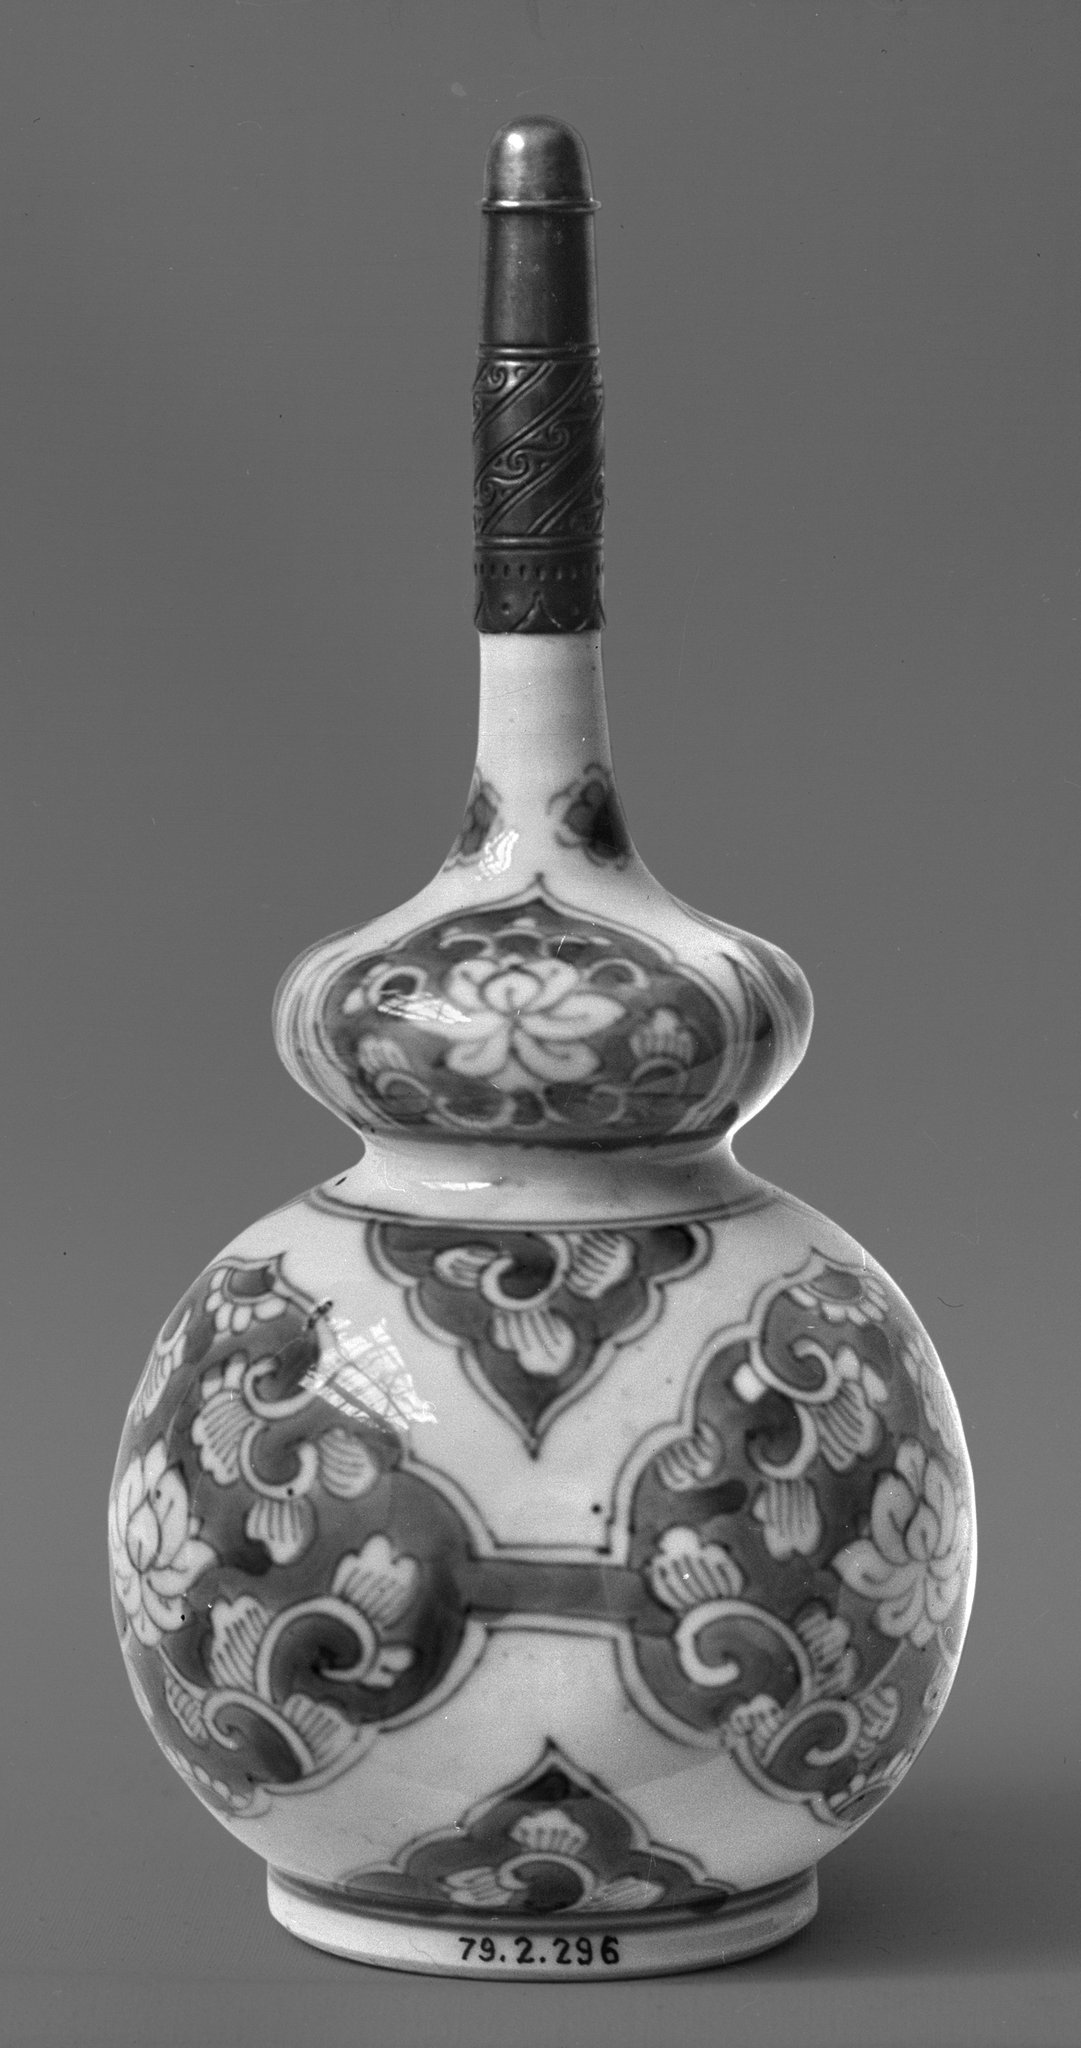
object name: sprinkler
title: Sprinkler in the form of double gourd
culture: chinese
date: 1667-1733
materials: cobalt, metal, porcelain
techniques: painting, underglaze